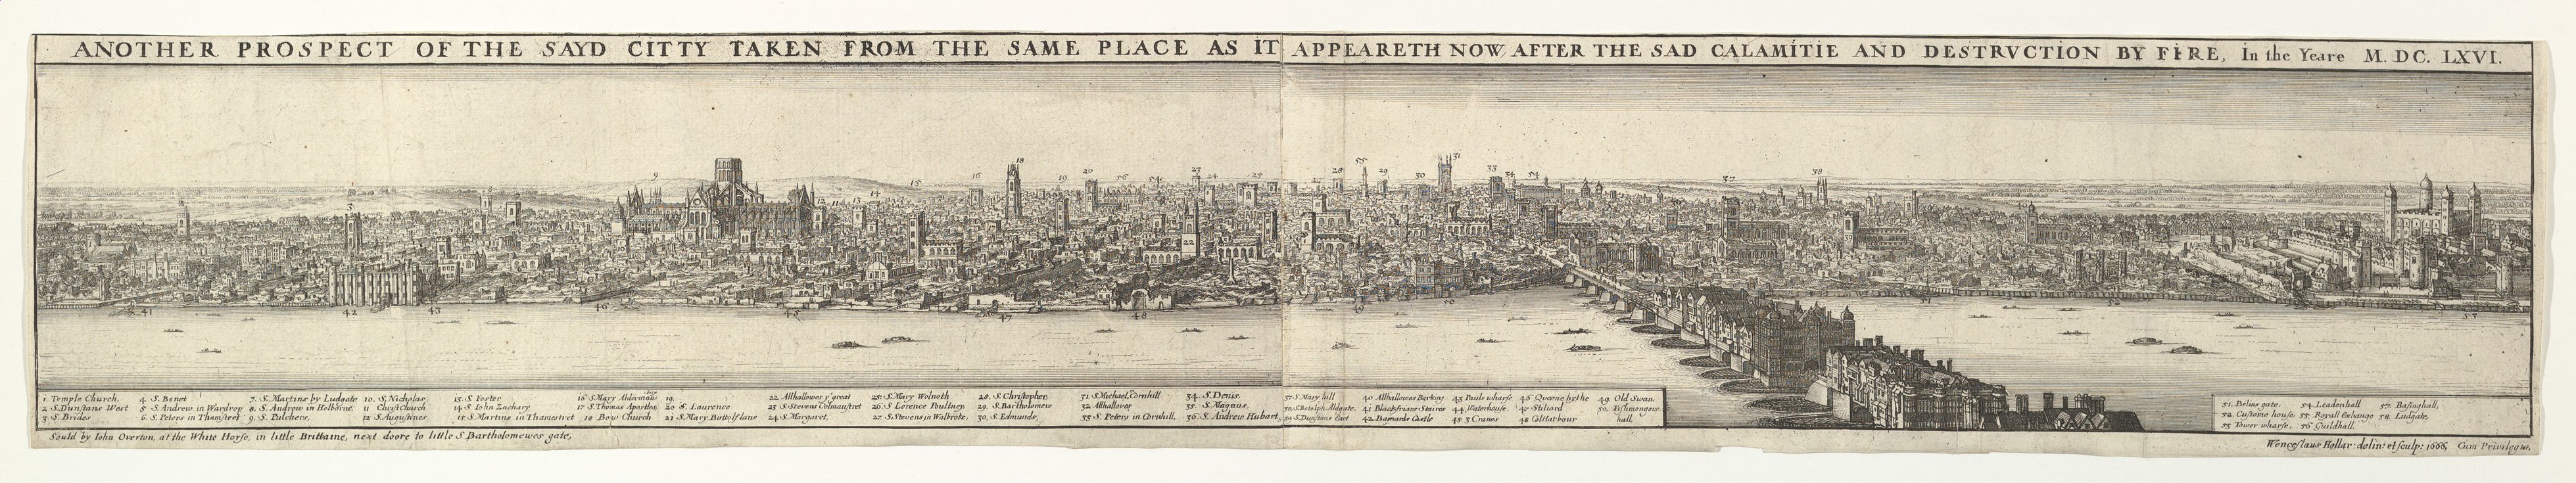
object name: print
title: Prospects of London Before and After the Great Fire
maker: wenceslaus hollar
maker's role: artist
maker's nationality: bohemian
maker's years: 1607-1677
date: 1666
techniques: etching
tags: buildings,rivers,london